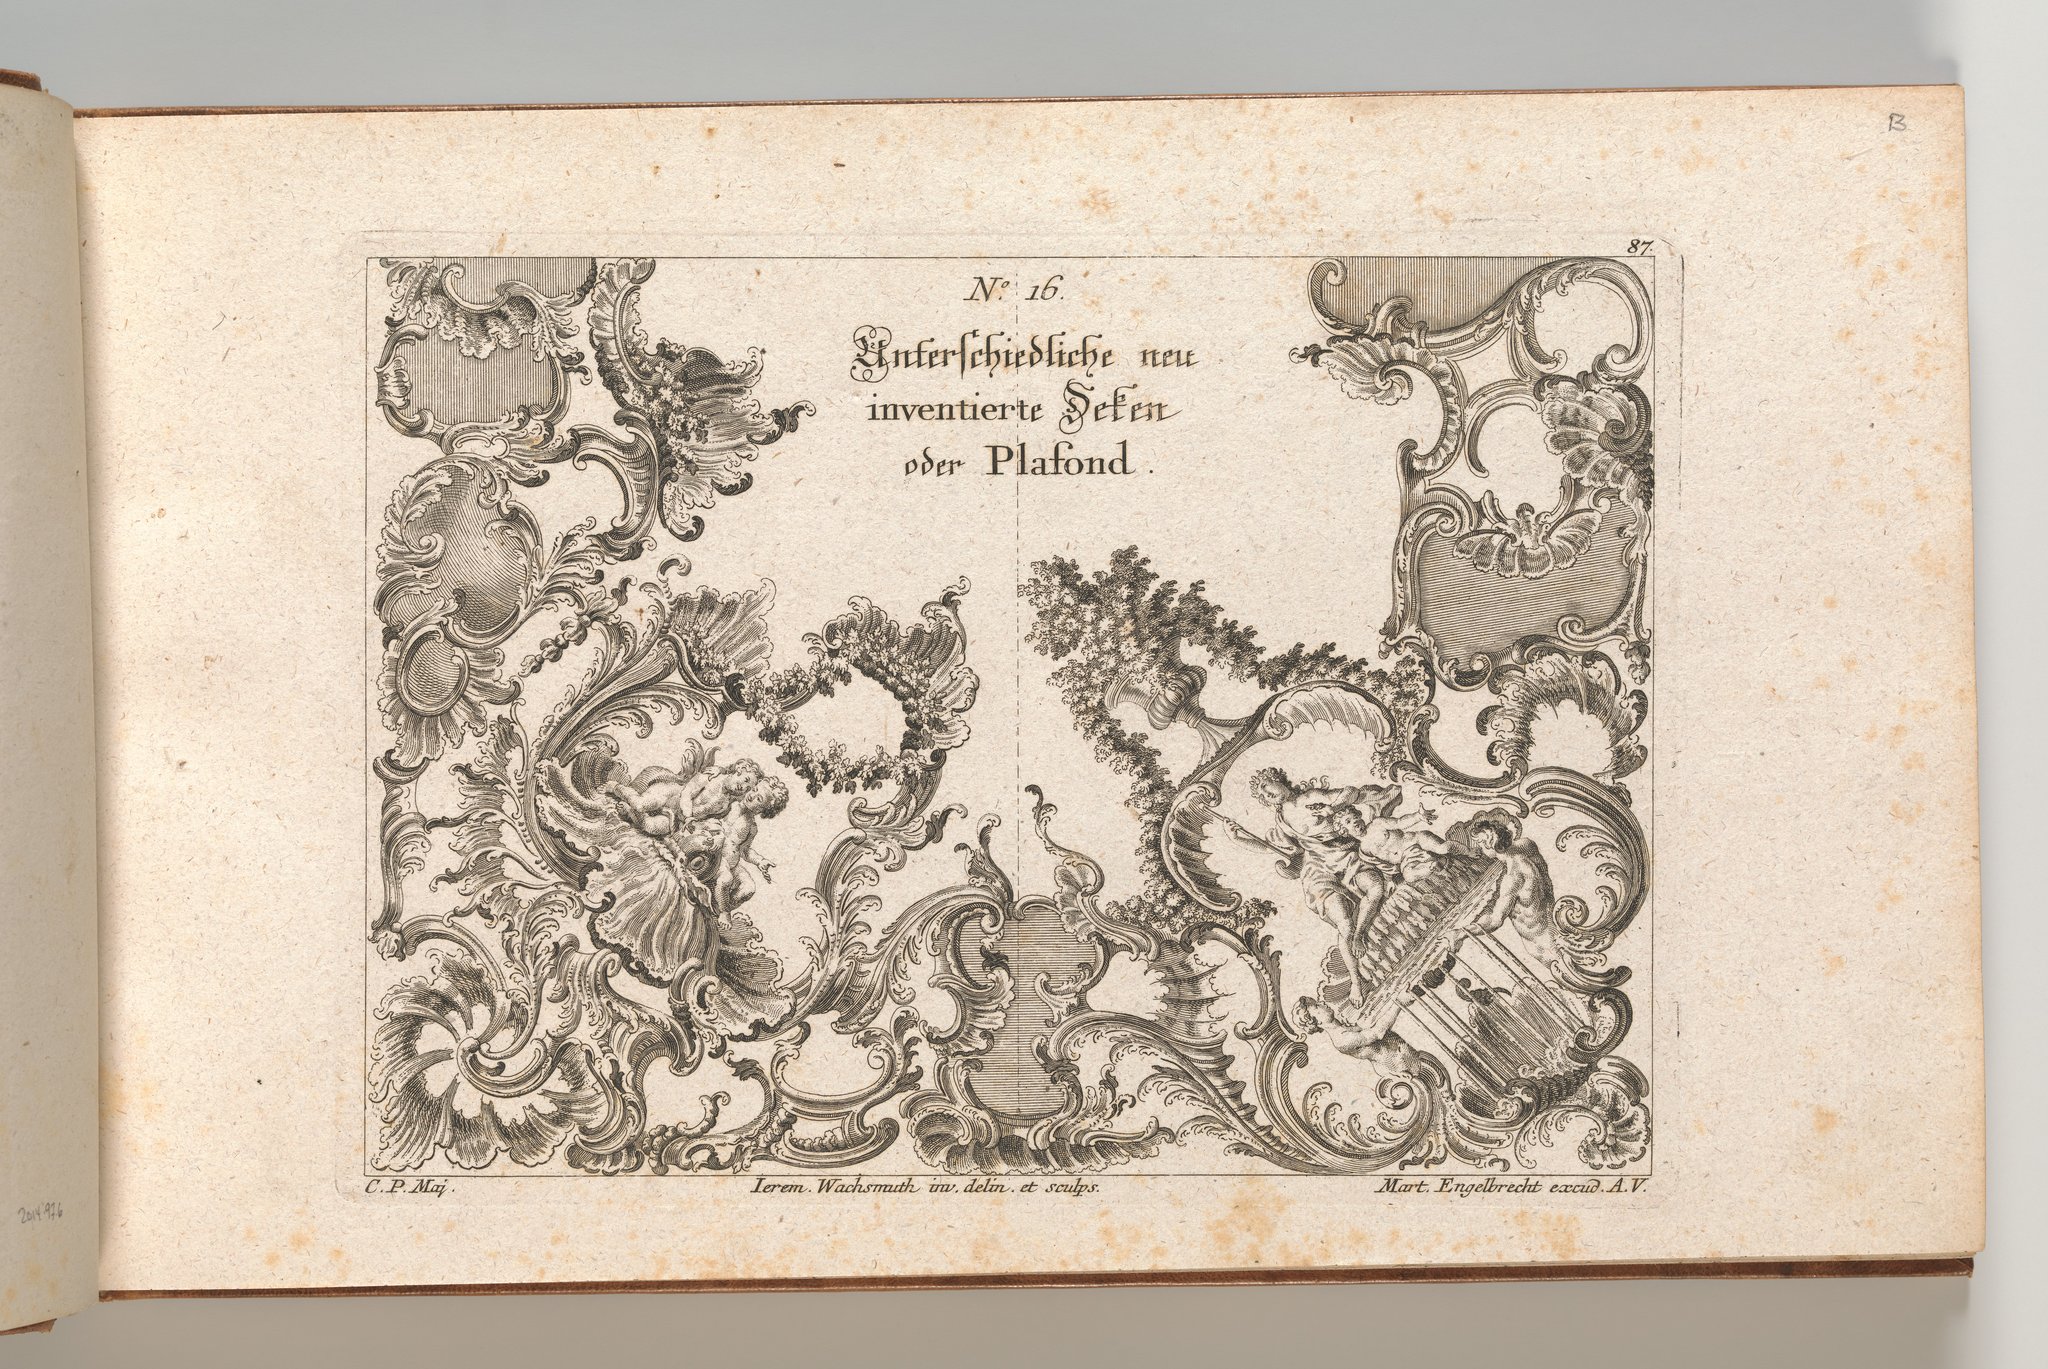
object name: album print ornament architecture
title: Two Designs for Ceiling Decorations, Plate 1 from 'Unterschiedliche neu inventierte Deken oder Plafond'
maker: jeremias wachsmuth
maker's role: artist and engraver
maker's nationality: german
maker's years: 1712-1771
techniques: etching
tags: cartouches